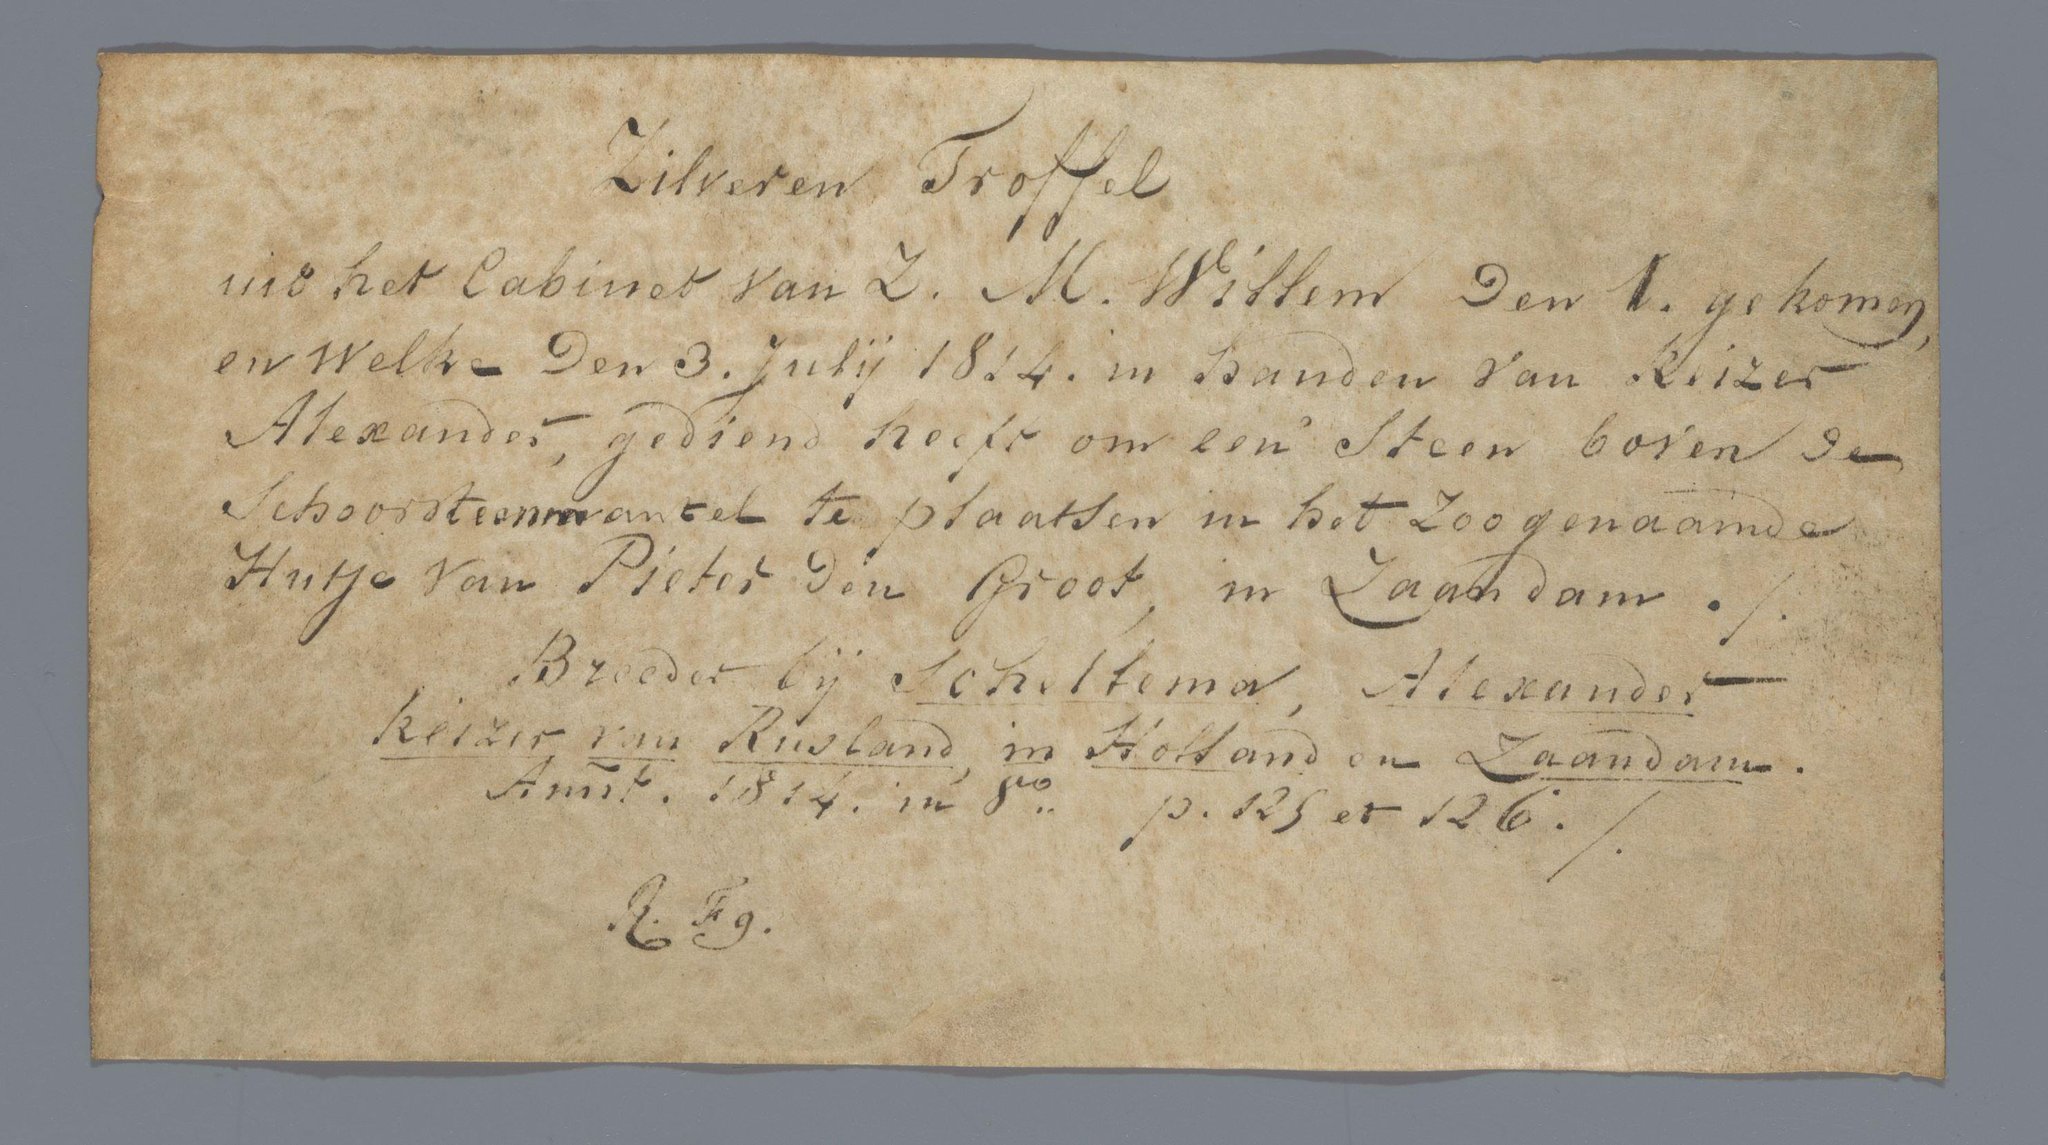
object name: verklaring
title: Verklaring van de zilveren troffel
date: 1814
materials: ink, parchment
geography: amsterdam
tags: peter i de grote (tsaar van rusland), alexander i (tsaar van rusland)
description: Perkamenten briefje, beschreven met zwarte inkt aan één zijde. Opschrift: Zilveren Troffel uit het Cabinet van Z. M. Willem den I gekomen en welke Den 3. Julij 1814. in handen van Keizer Alexander gediend heeft om een Steen boven den Schoorsteenmantel te plaatsen in het Zogenaamde Huisje van Pieter den Groot. Opmerking: Zie inv. nrs. NG-NM-1121-a en c.